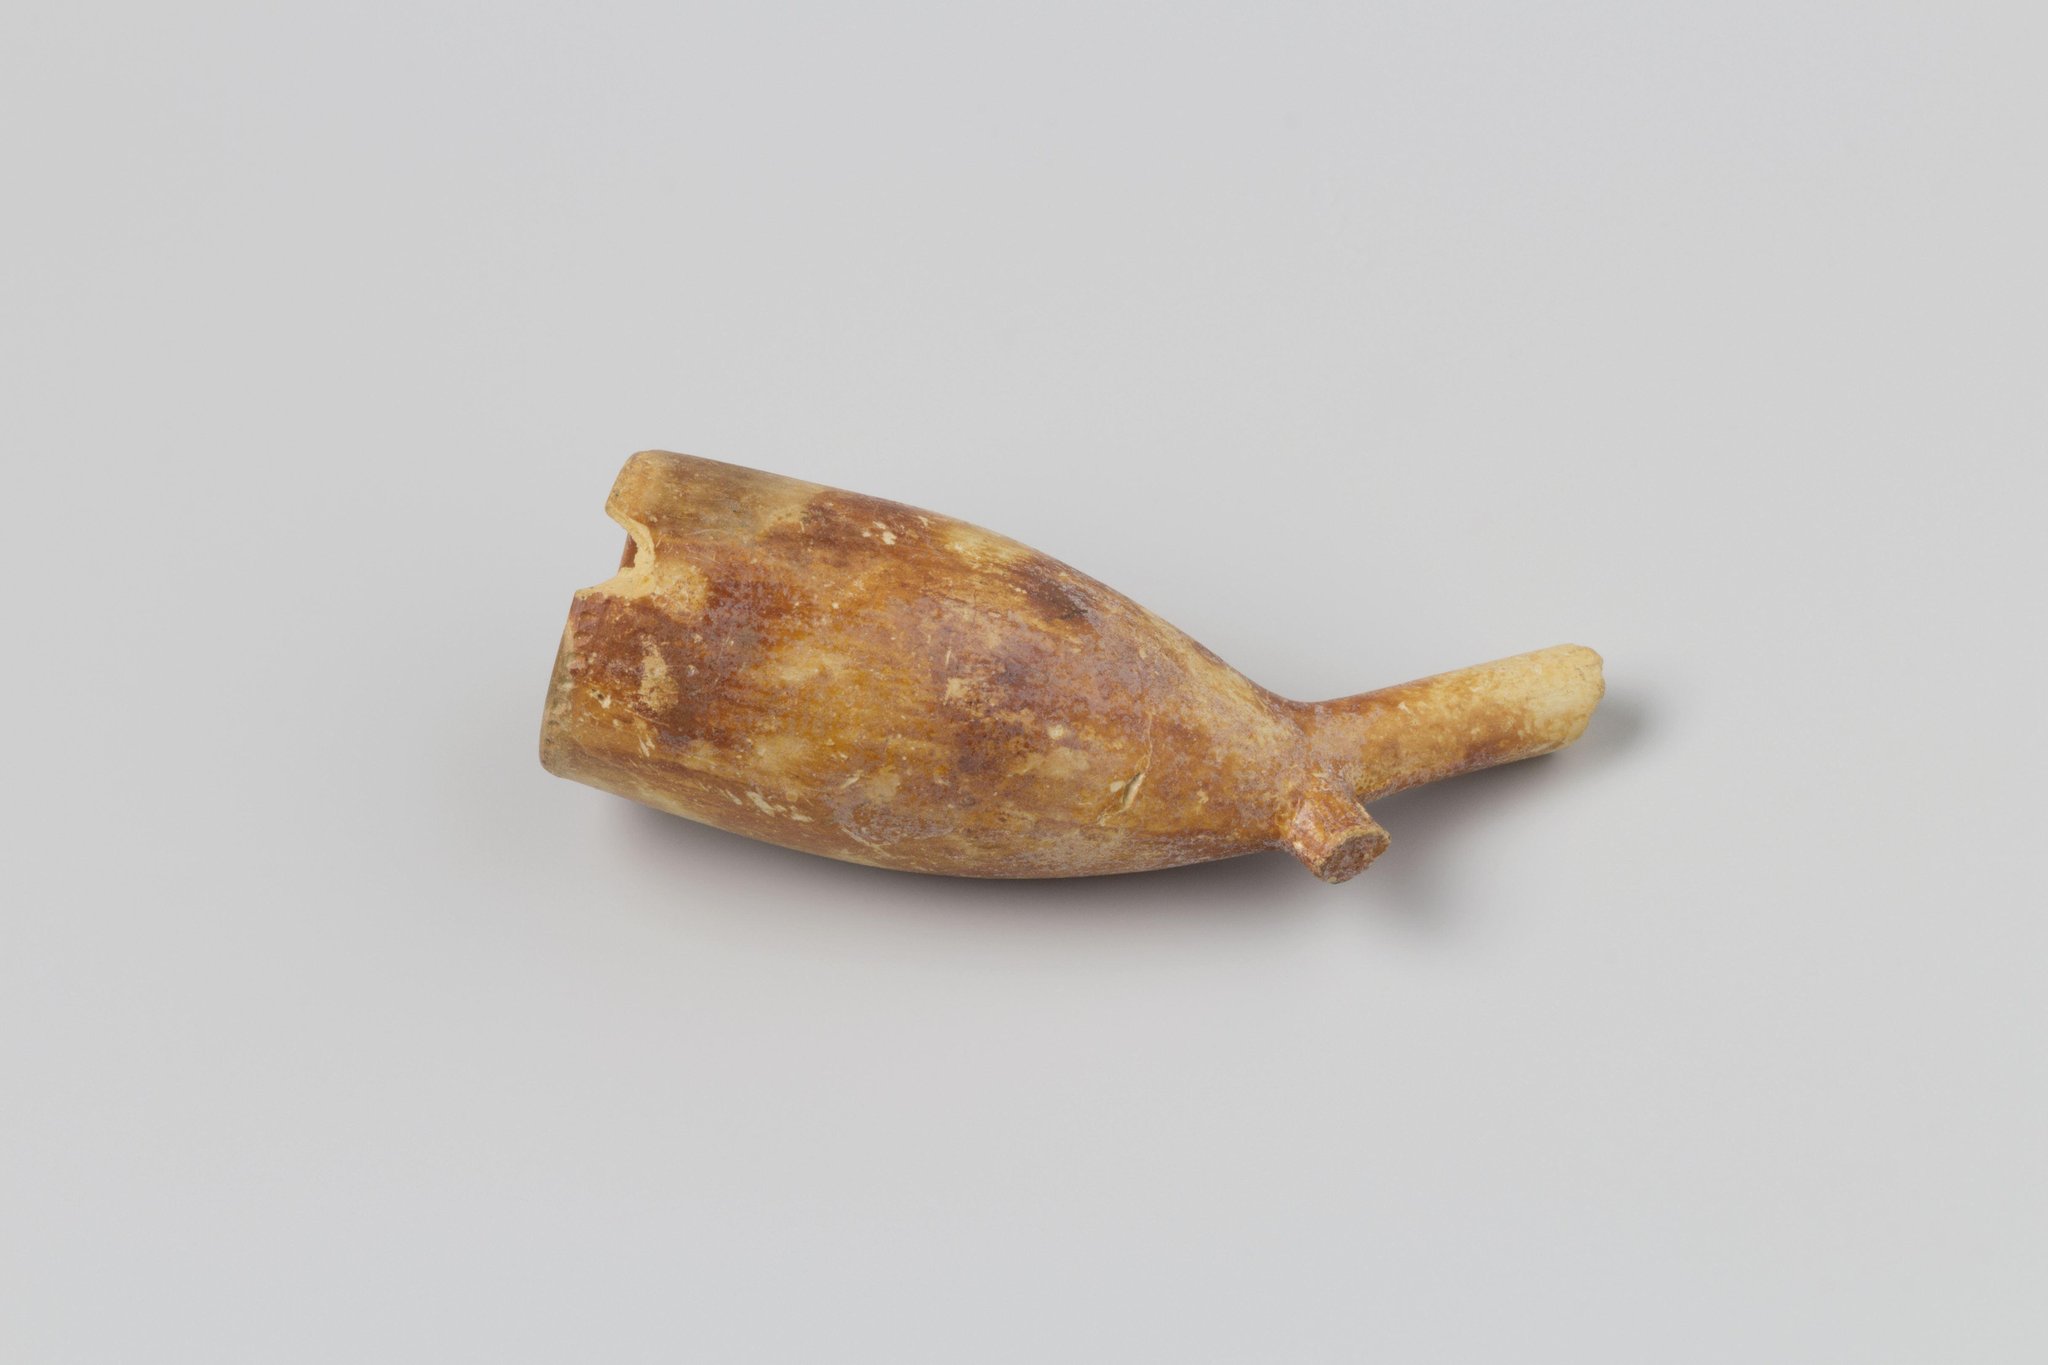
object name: pipe bowl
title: Pijpenkop uit het wrak van de Oost-Indiëvaarder Hollandia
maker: Anonymous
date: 1700-1743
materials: clay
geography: netherlands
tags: verenigde oostindische compagnie, hollandia (schip), annet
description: Pipe, bowl, heelmark: crowned 47; 2hsm1,2.